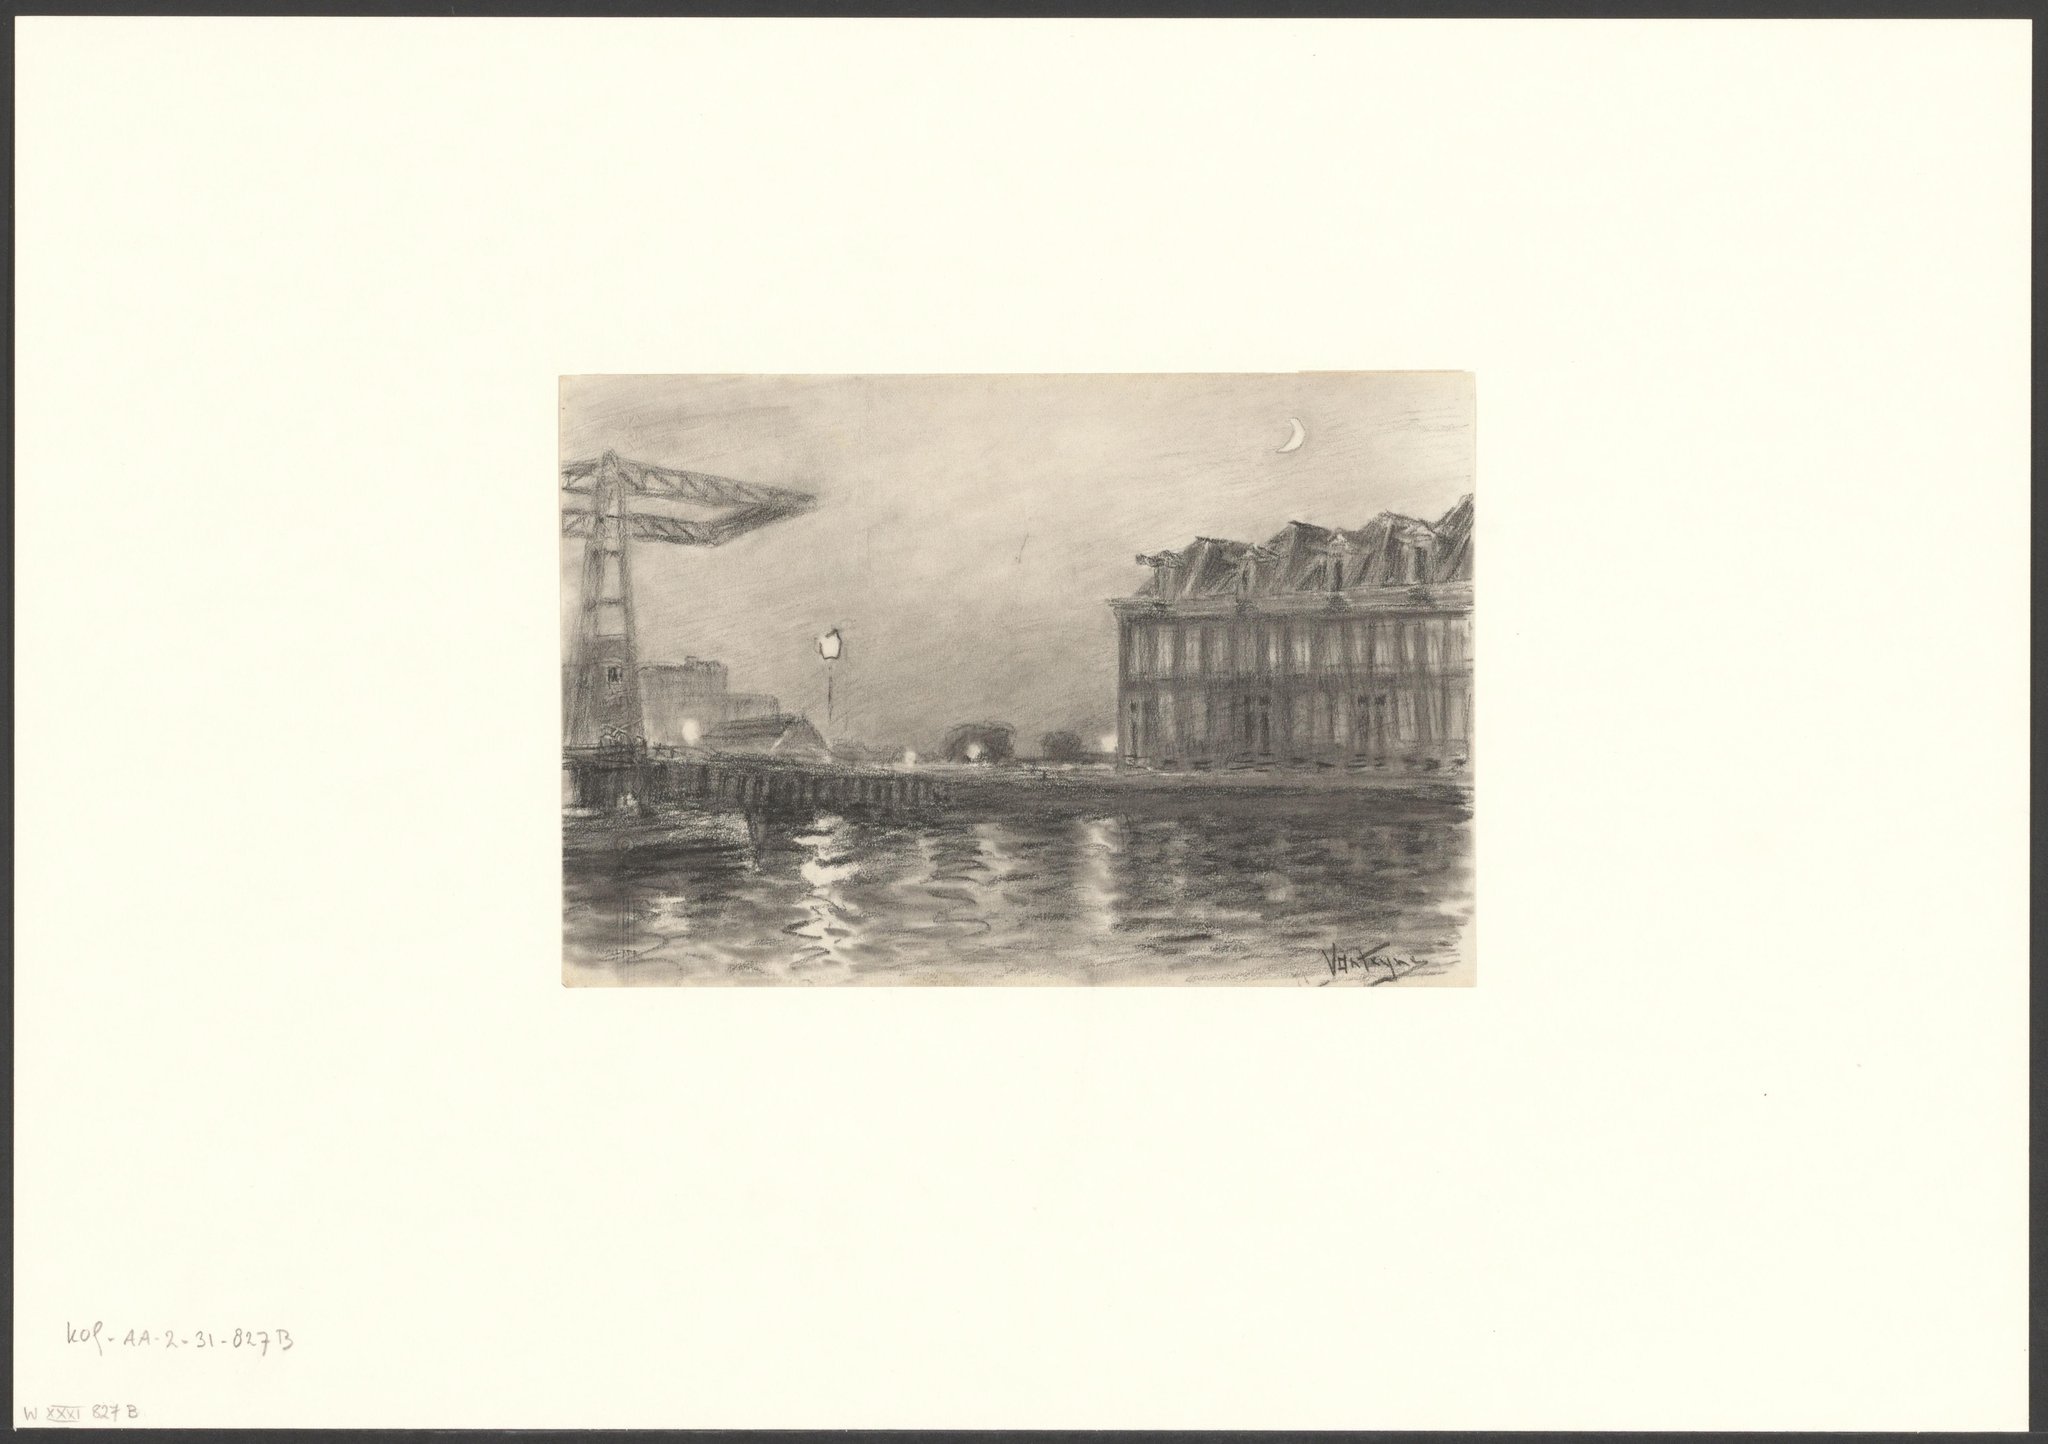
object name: drawing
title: Gezicht op de Kostverlorenvaart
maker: anthonie van teijn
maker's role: draughtsman, painter, print maker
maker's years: 1863-1943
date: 1907-1927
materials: chalk, paper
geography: amsterdam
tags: city-view in general; 'veduta', river, bridge in city across river, canal, etc.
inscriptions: signature: ‘VanTeyne’, inscription: ‘De Kostverloren vaart (...) Juli 1927. / vanEck’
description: Tekening binnen de Atlas Van Eck ingedeeld op wijknummer 31.